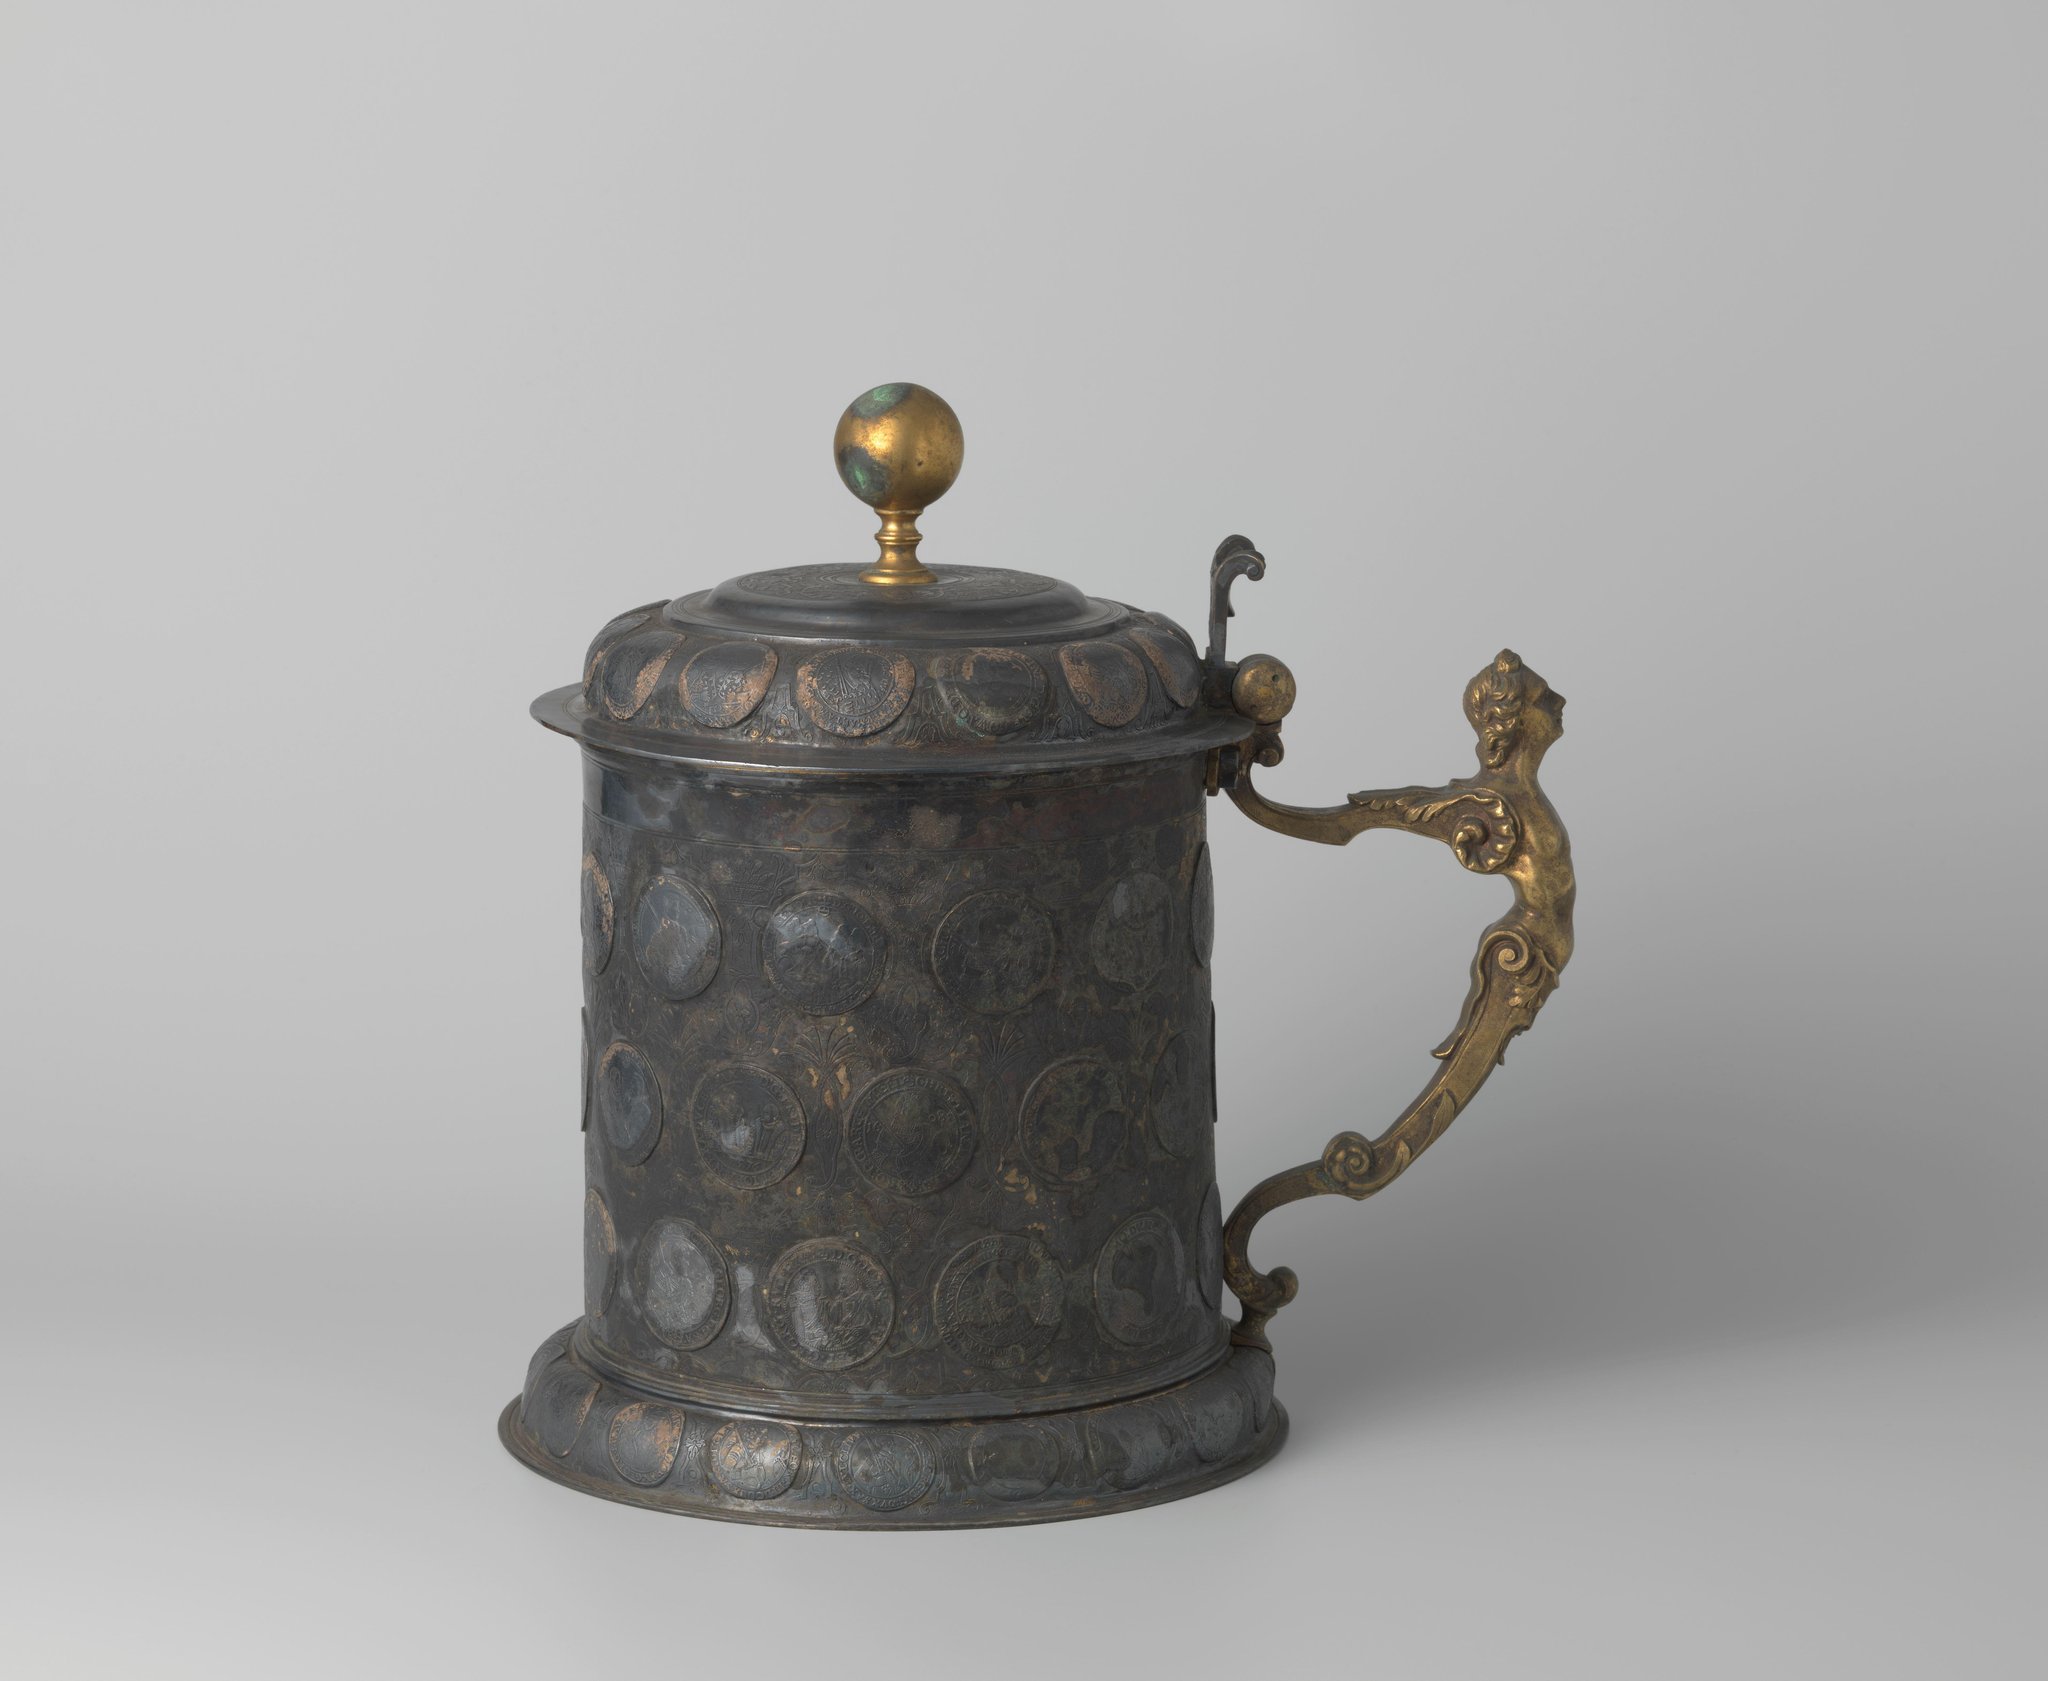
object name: drinkkan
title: Galvanoplastische reproductie van een drinkkan waarin Duitse daalders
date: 1881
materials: copper, silver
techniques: gilding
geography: london